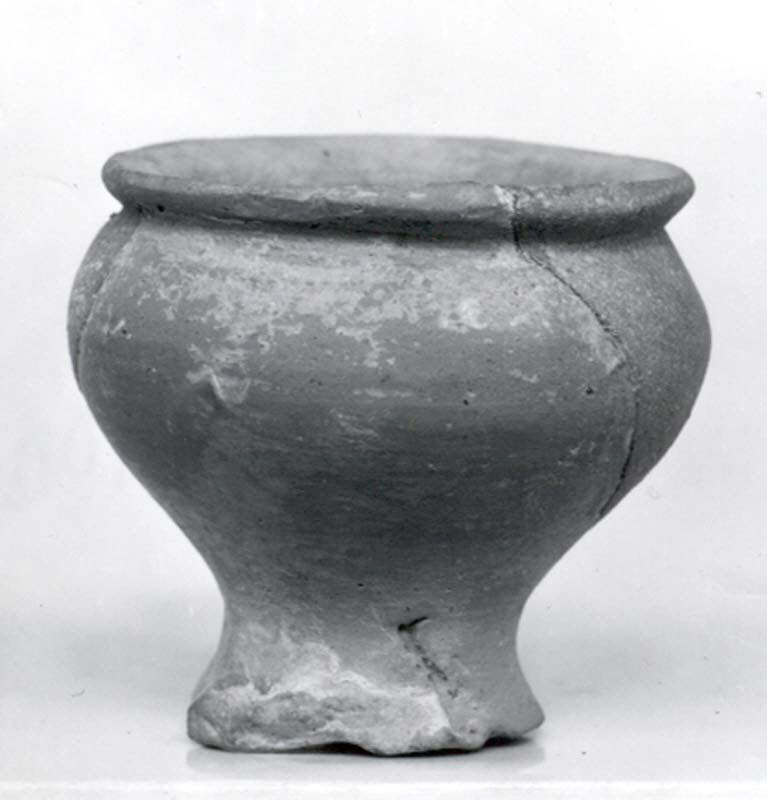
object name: bowl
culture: sasanian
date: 201-700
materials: ceramic, glaze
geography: iran